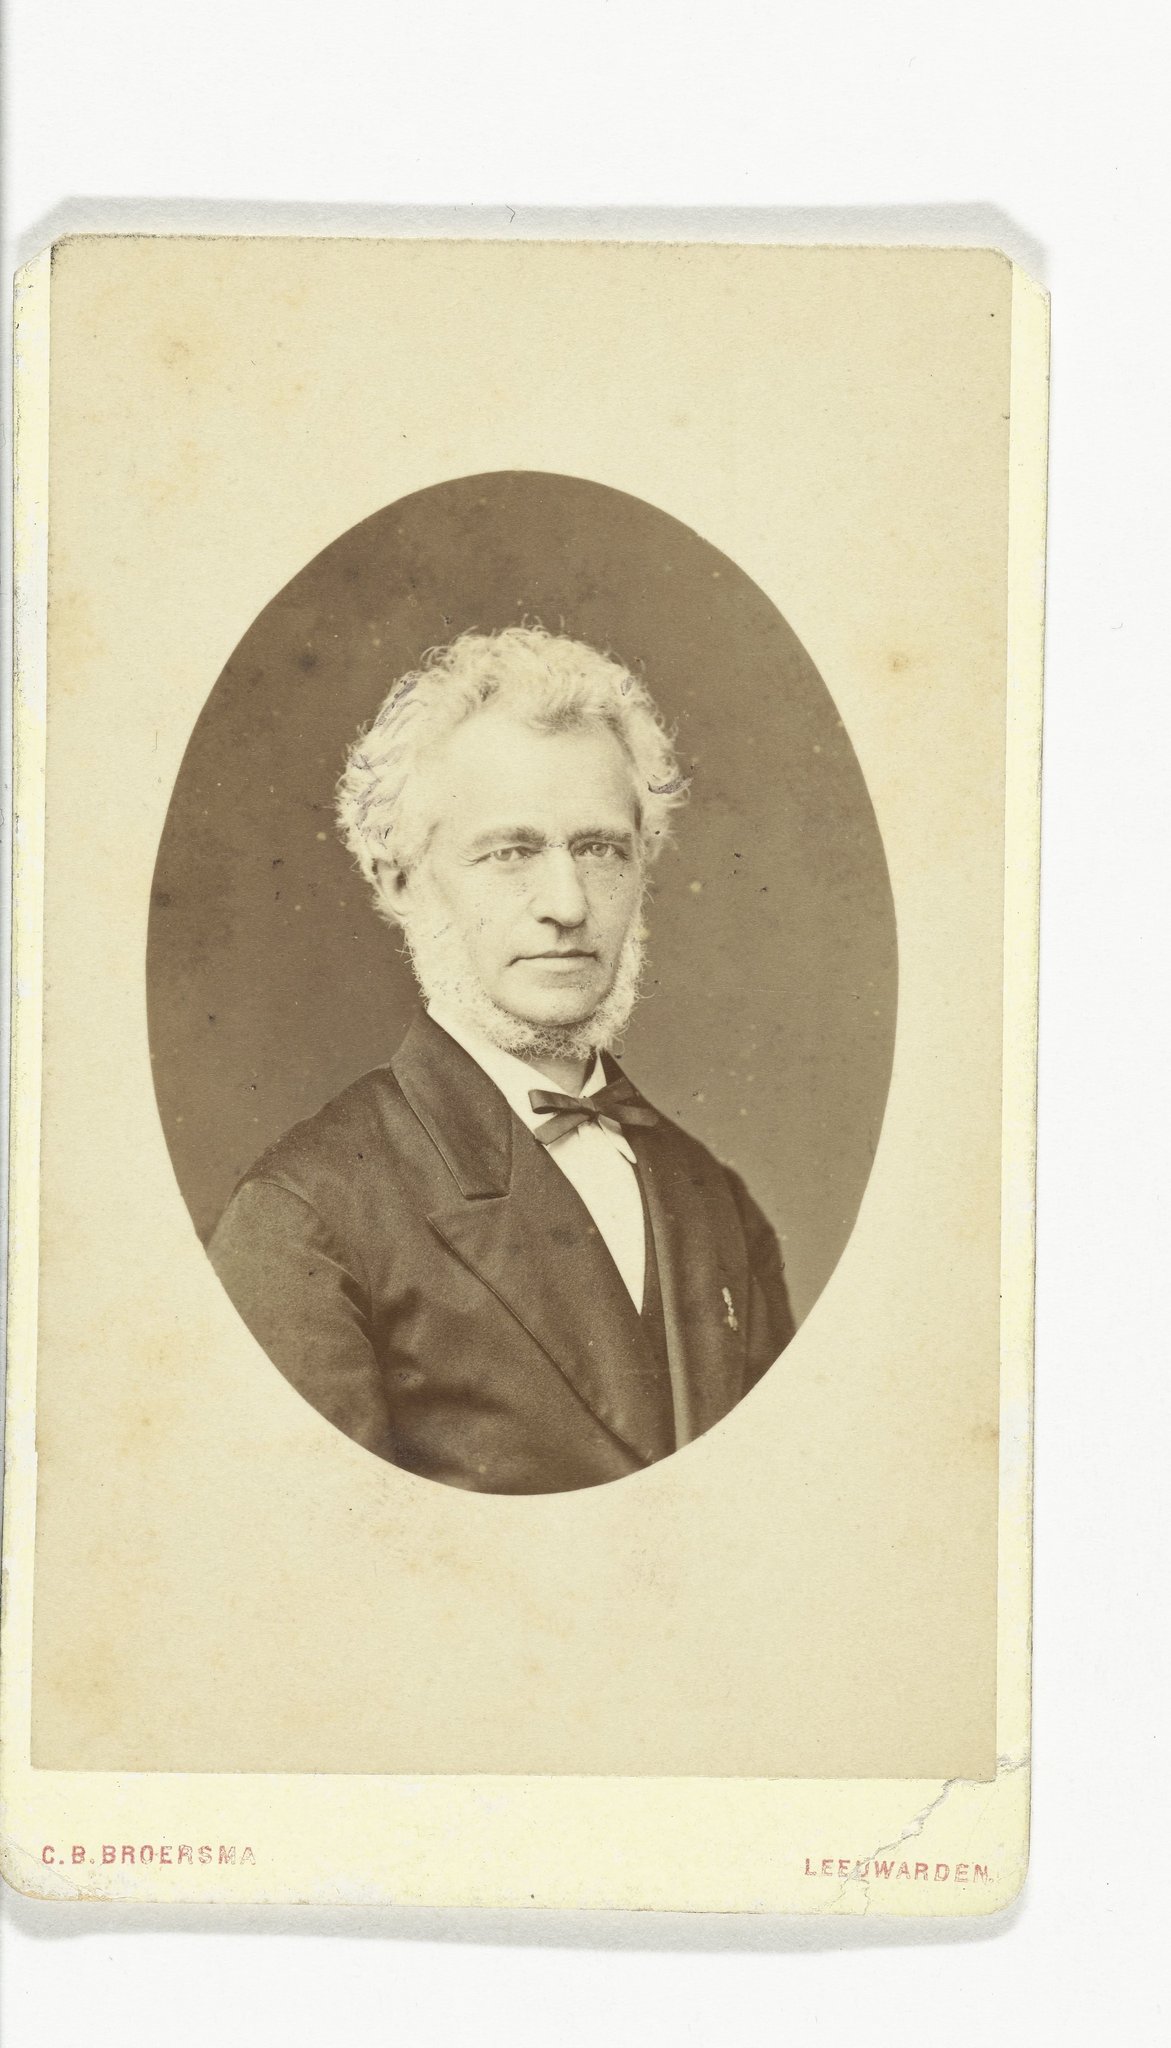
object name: photograph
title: Portret van de heer H.N. Thoden van Velzen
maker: cornelis bernardus broersma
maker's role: fotograaf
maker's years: 1841-1919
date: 1879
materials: cardboard, paper, photographic support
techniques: albumen print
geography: leeuwarden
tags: historical persons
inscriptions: inscription: ‘H.U. Thoden van Velzen geb 1810, Groninger 1830, Ned te Leeuwarden tijdens het portr ong. 49 (1890) 80 jaar oud.’, signature: ‘C.B. Broersma, photographische kunstinrichting vleeschmarkt Leeuwarden.’, signature: ‘C.B. Broersma Leeuwarden’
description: Carte-de-visite is onderdeel van een groep portretten aangeboden aan A.J. Nijland, verzamelaar van historieprenten.